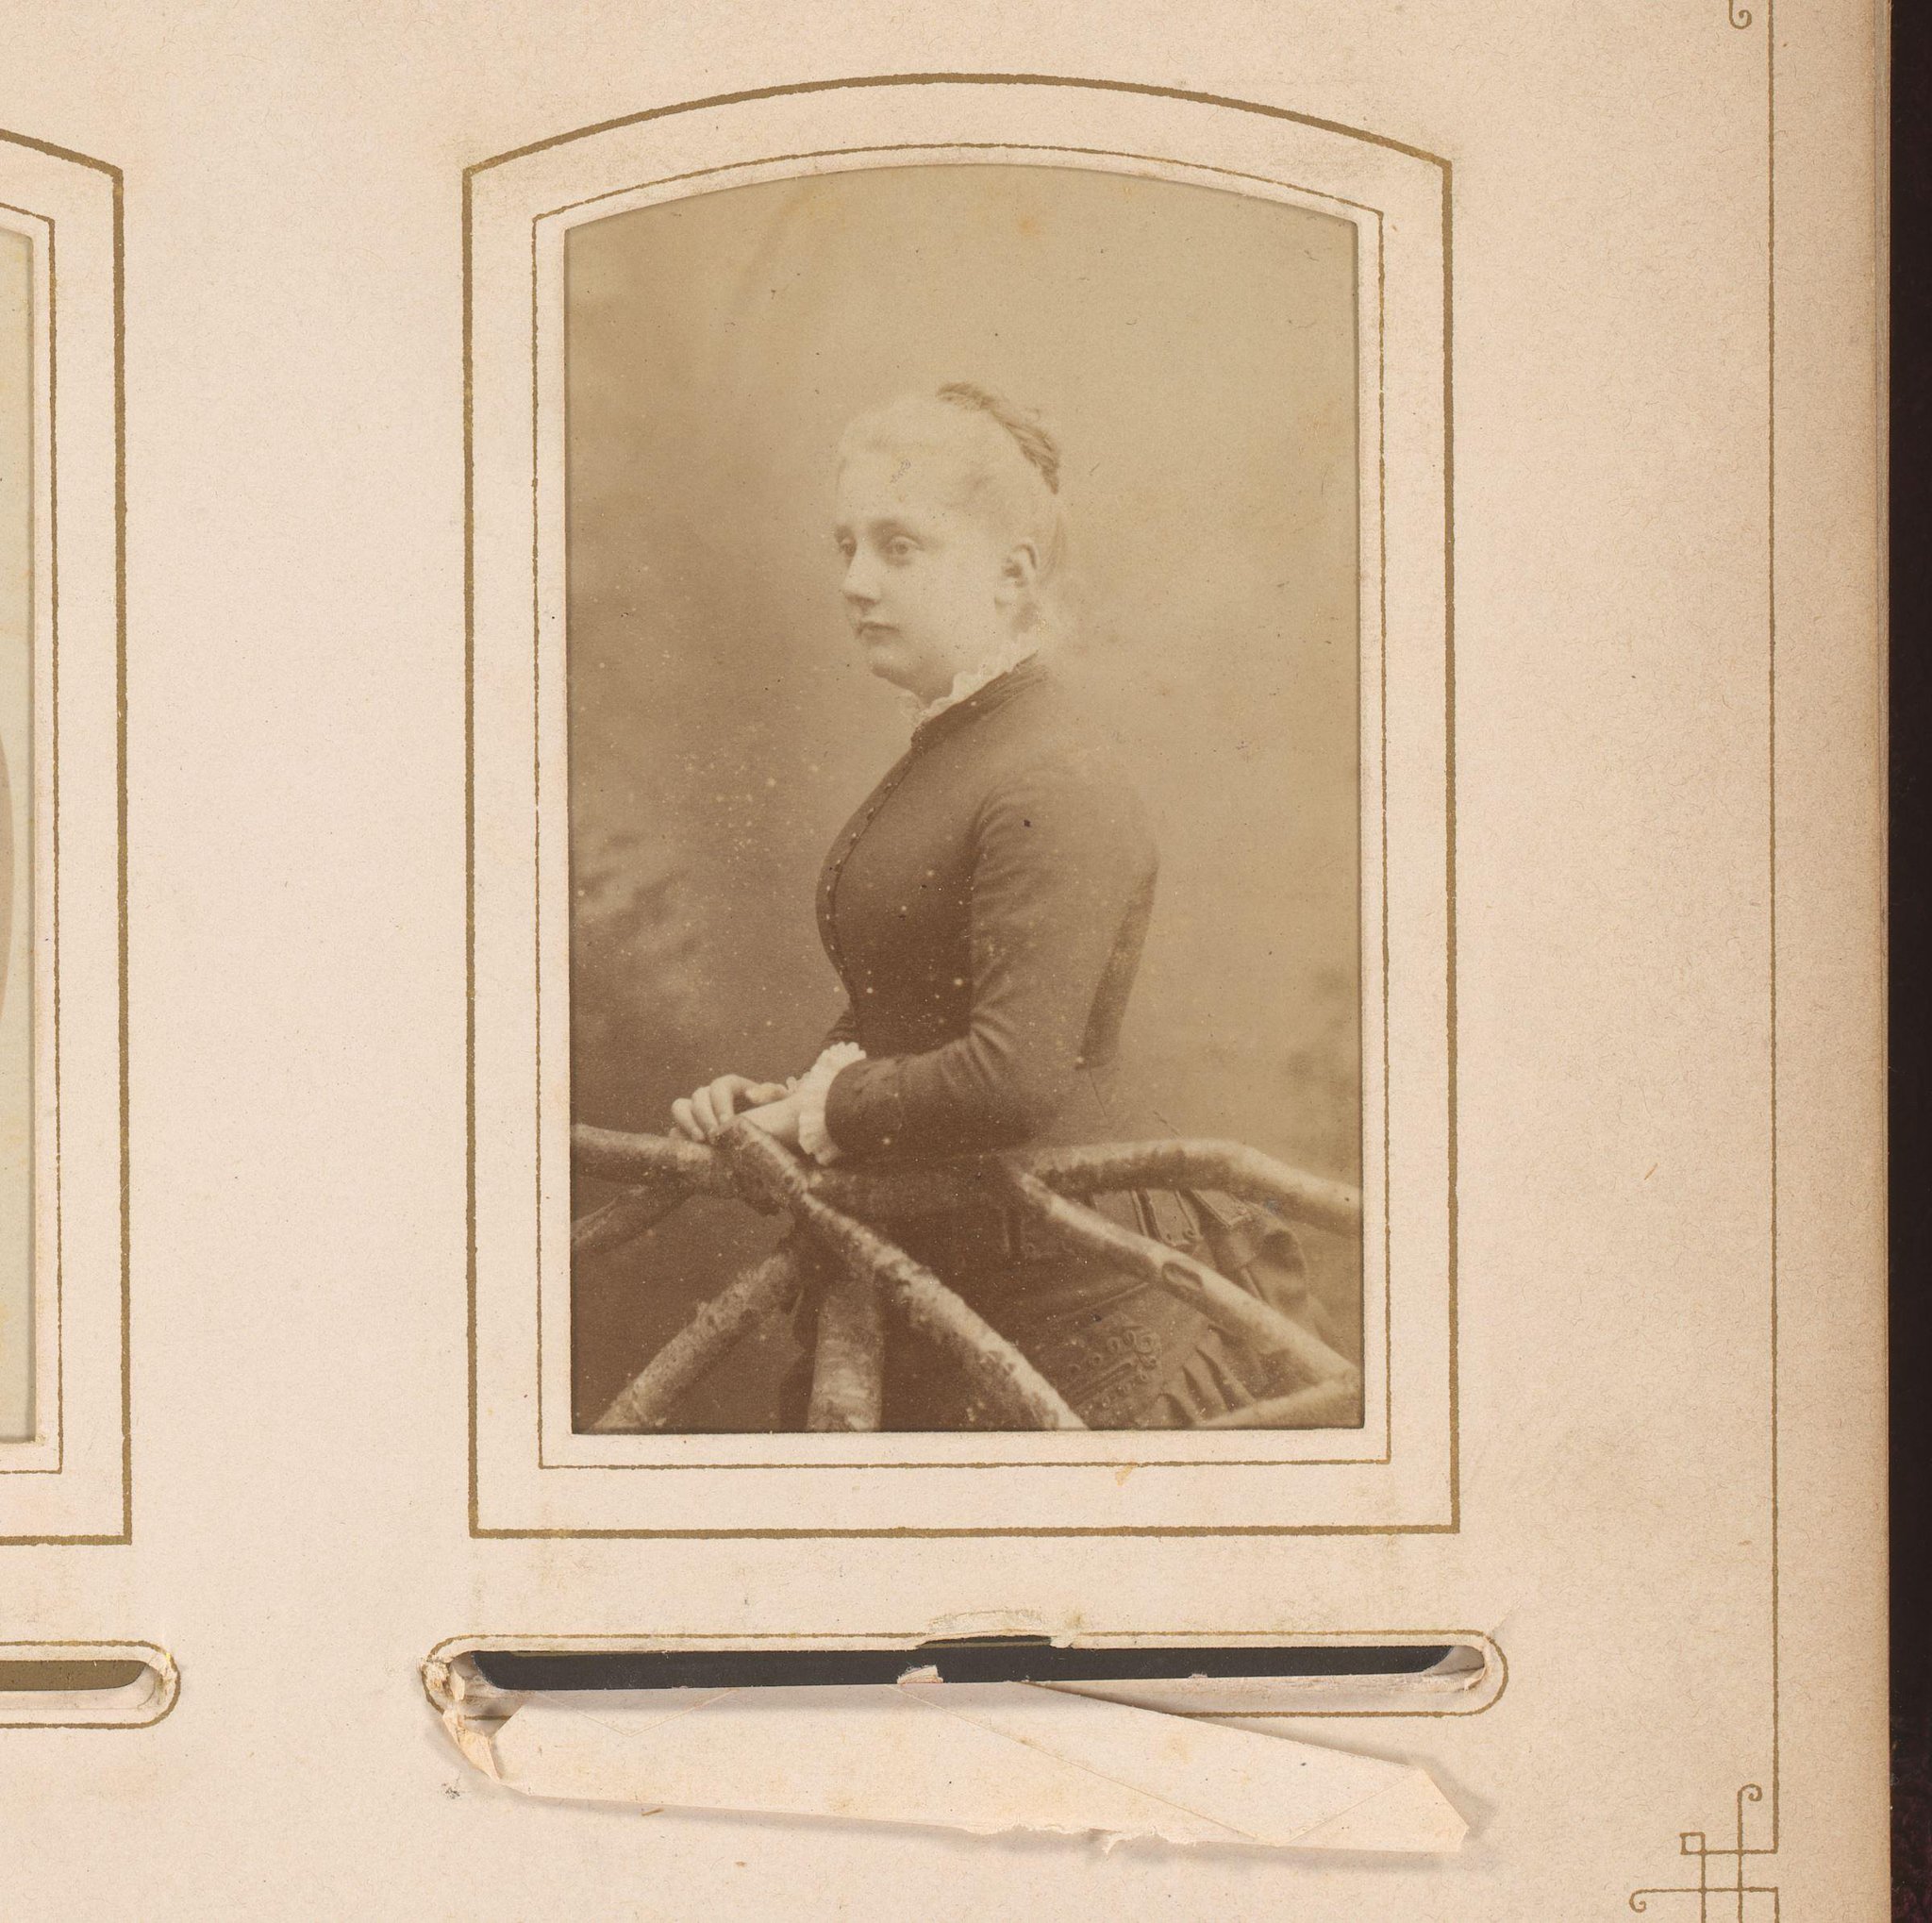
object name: carte de visite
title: Portret van een jonge vrouw, staand bij een hek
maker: adolphe zimmermans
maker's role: fotograaf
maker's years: 1858-1922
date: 1879-1883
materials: cardboard, photographic support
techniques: albumen print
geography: the hague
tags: adolescent, young woman, maiden, historical persons - bb - woman, fence, wall, paling, standing figure - aa - female human figure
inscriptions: inscription: ‘Adolphe Zimmermans/ Photographe/ La Haye/ Riemerstraat No. 48.’